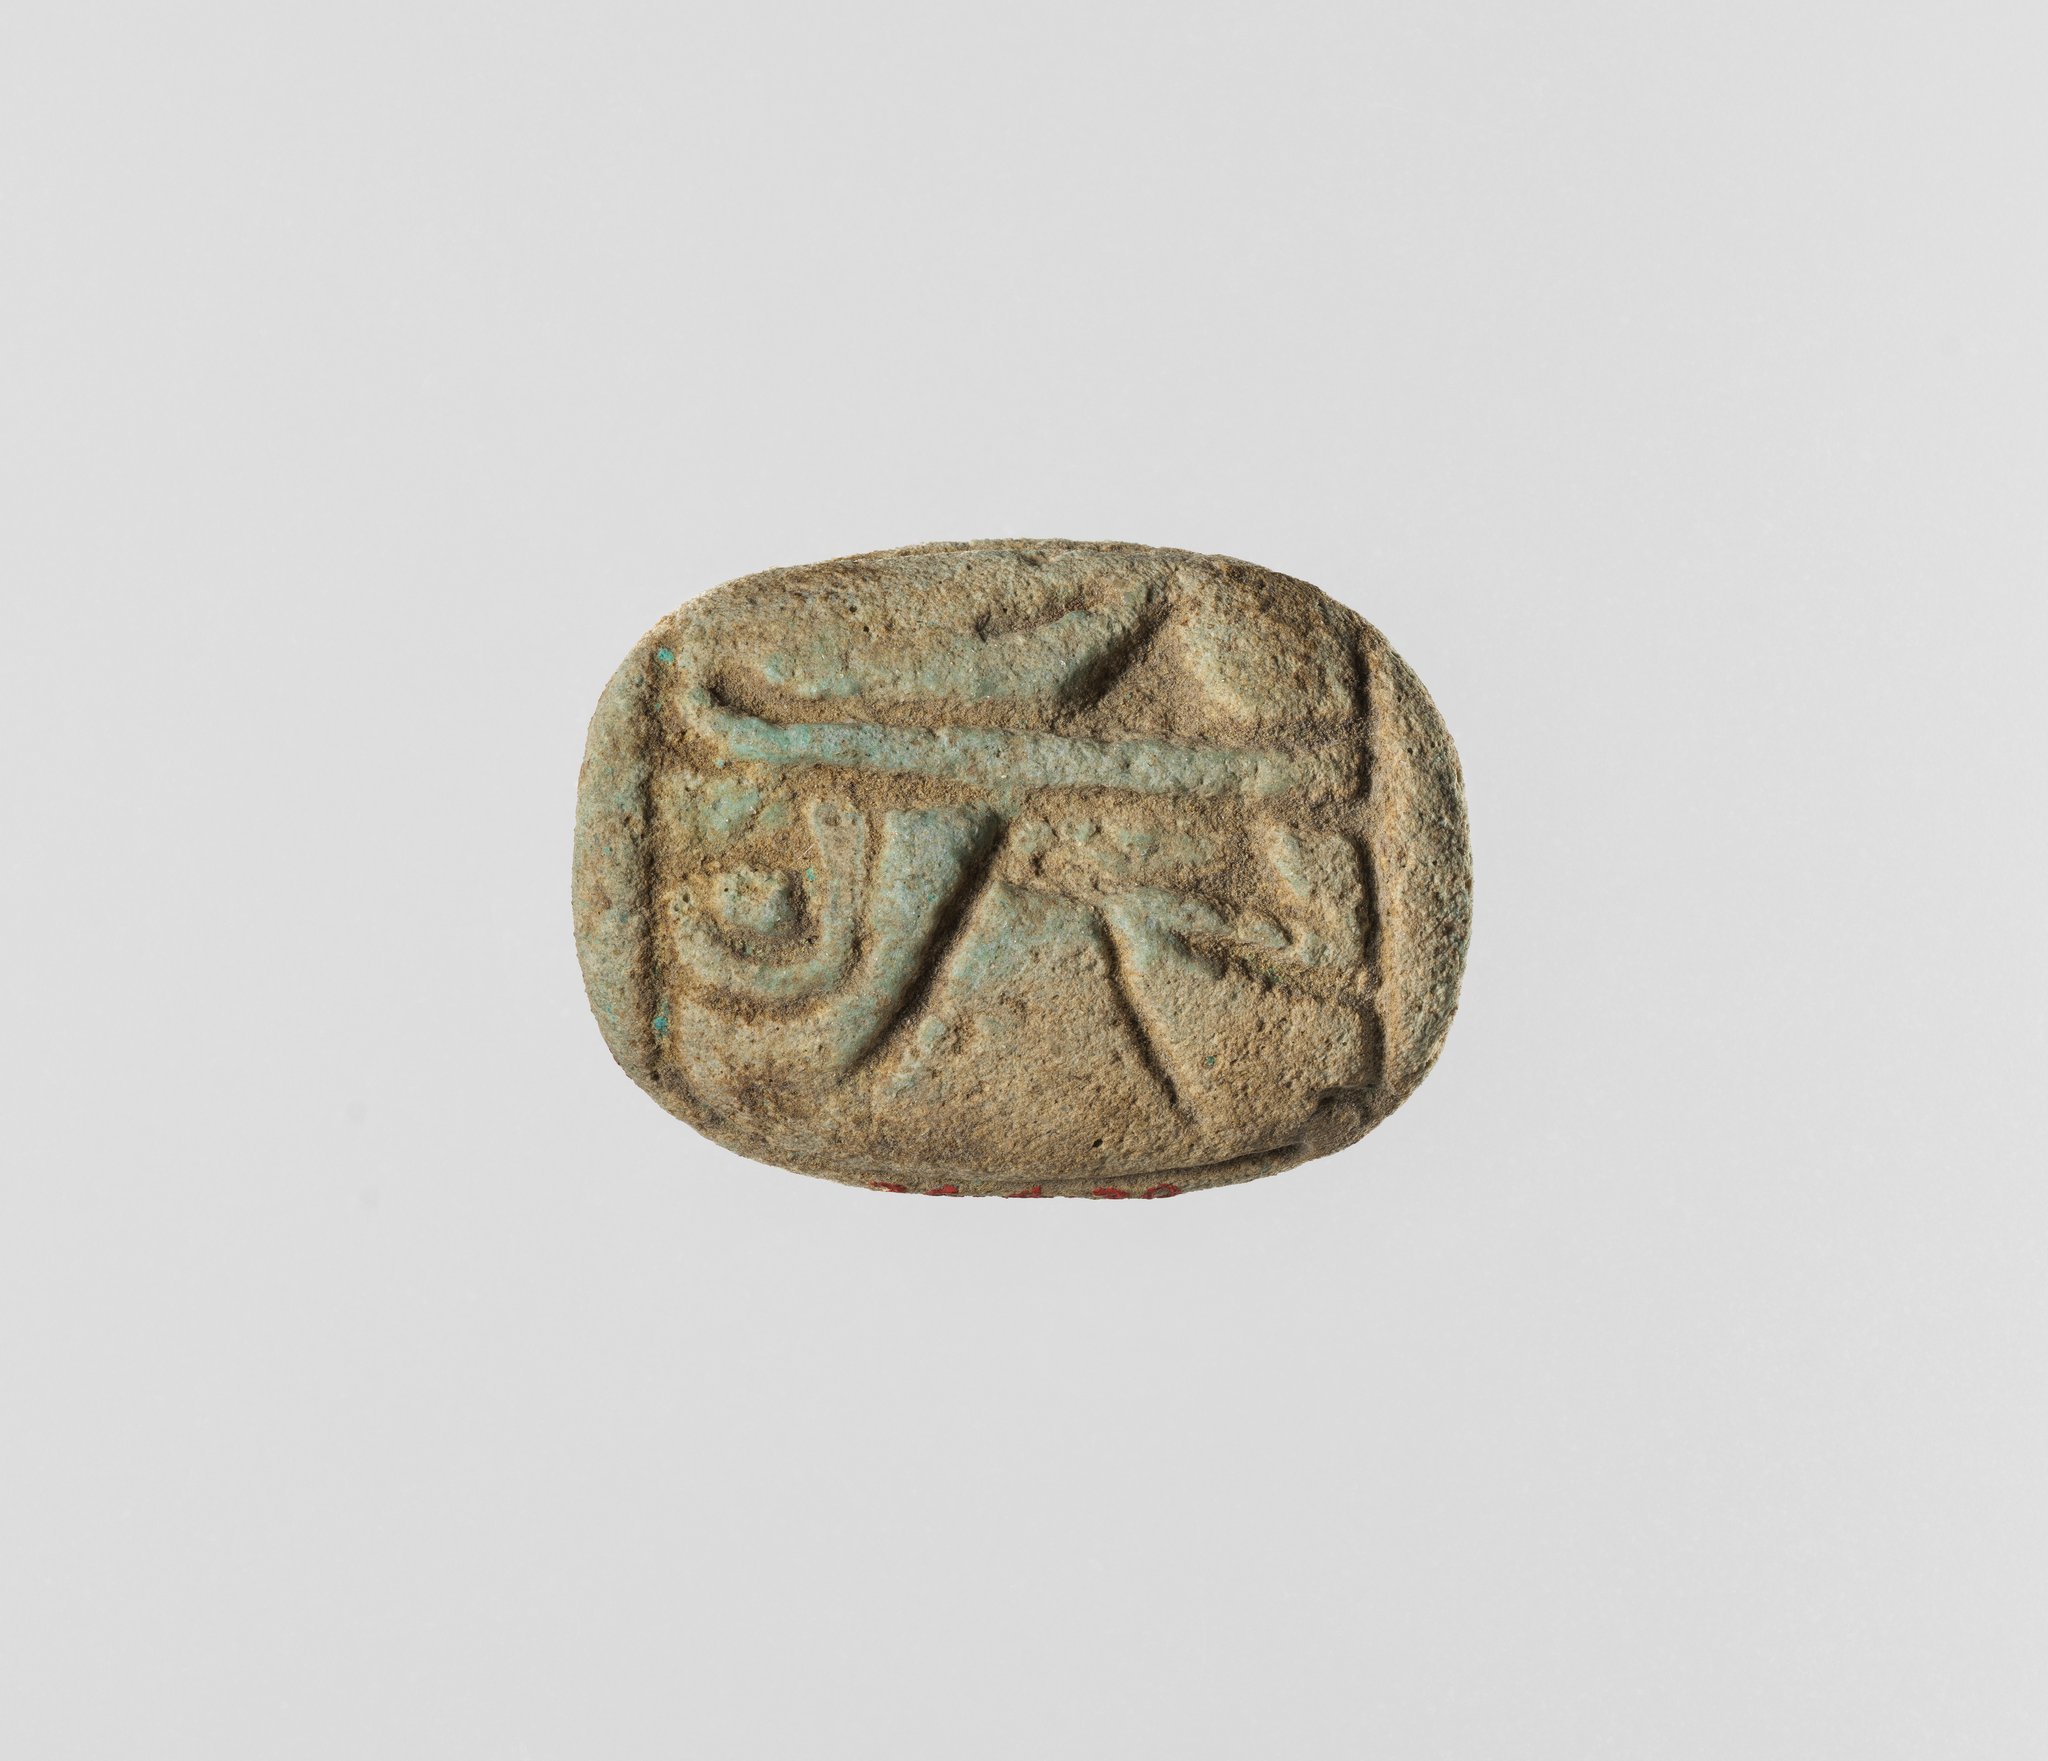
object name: amulet, wedjat eye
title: Wedjat eye amulet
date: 750-300 BCE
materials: faience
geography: nubia